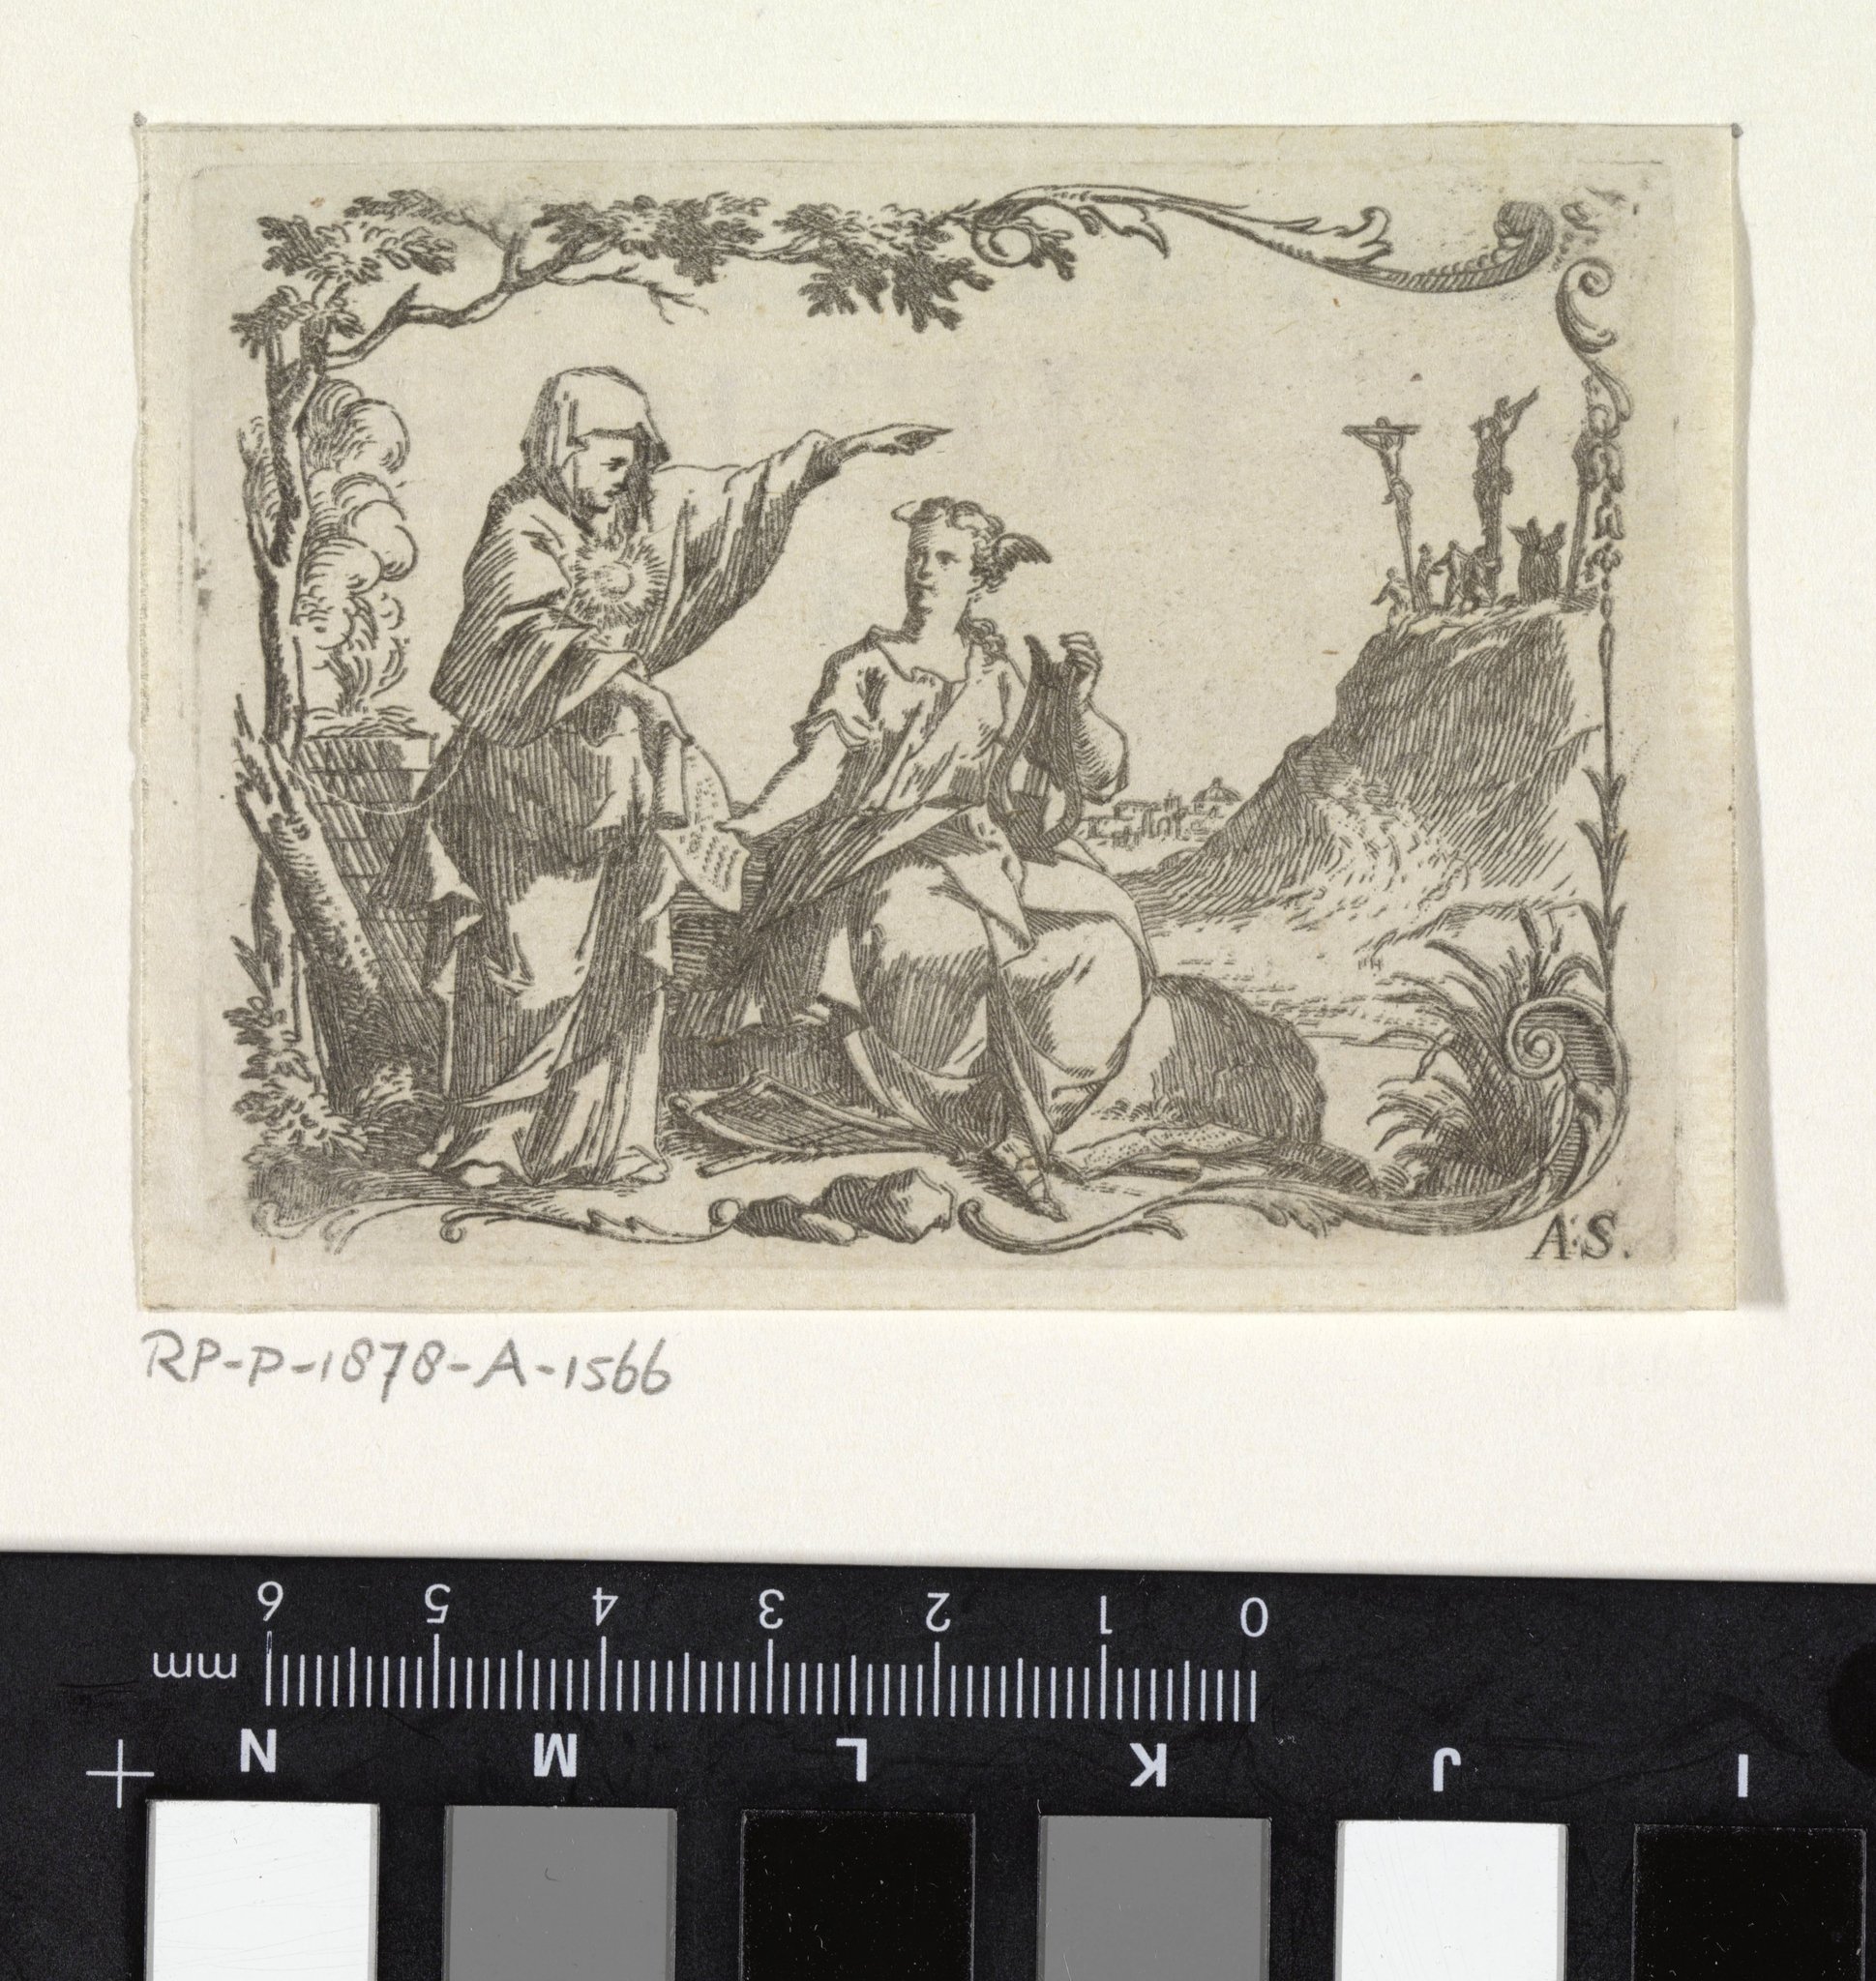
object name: print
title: Allegorische voorstelling met Geloof en Poëzie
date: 1746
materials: paper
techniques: etching, letterpress printing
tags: faith, 'fides'; 'fede', 'fede catholica', 'fede christiana', 'fede christiana catholica' (ripa) ~ one of the three theological virtues (+ variant), crucified christ with other persons - dd - the three crosses, symbolic representations, allegories and emblems ~ poetry; 'poesia' (ripa)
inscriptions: collector's mark: Lugt 2228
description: Het Geloof wijst de zittende Poëzie op de berg Golgotha met de drie gekruisigden achter hen. Onder en boven de afbeelding de titel en auteur van het boek en het impressum.